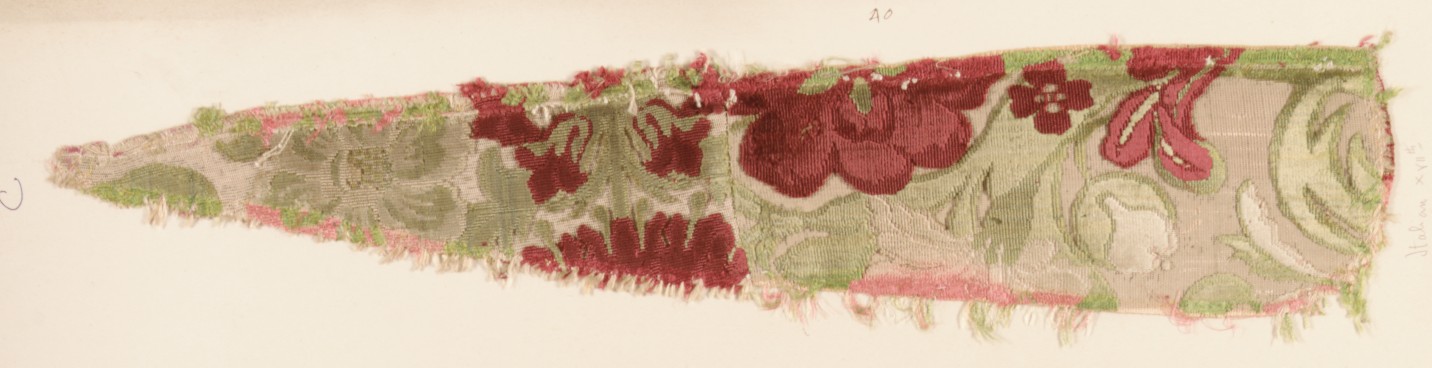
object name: fragment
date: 1601-1700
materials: metal thread, silk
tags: flowers,leaves